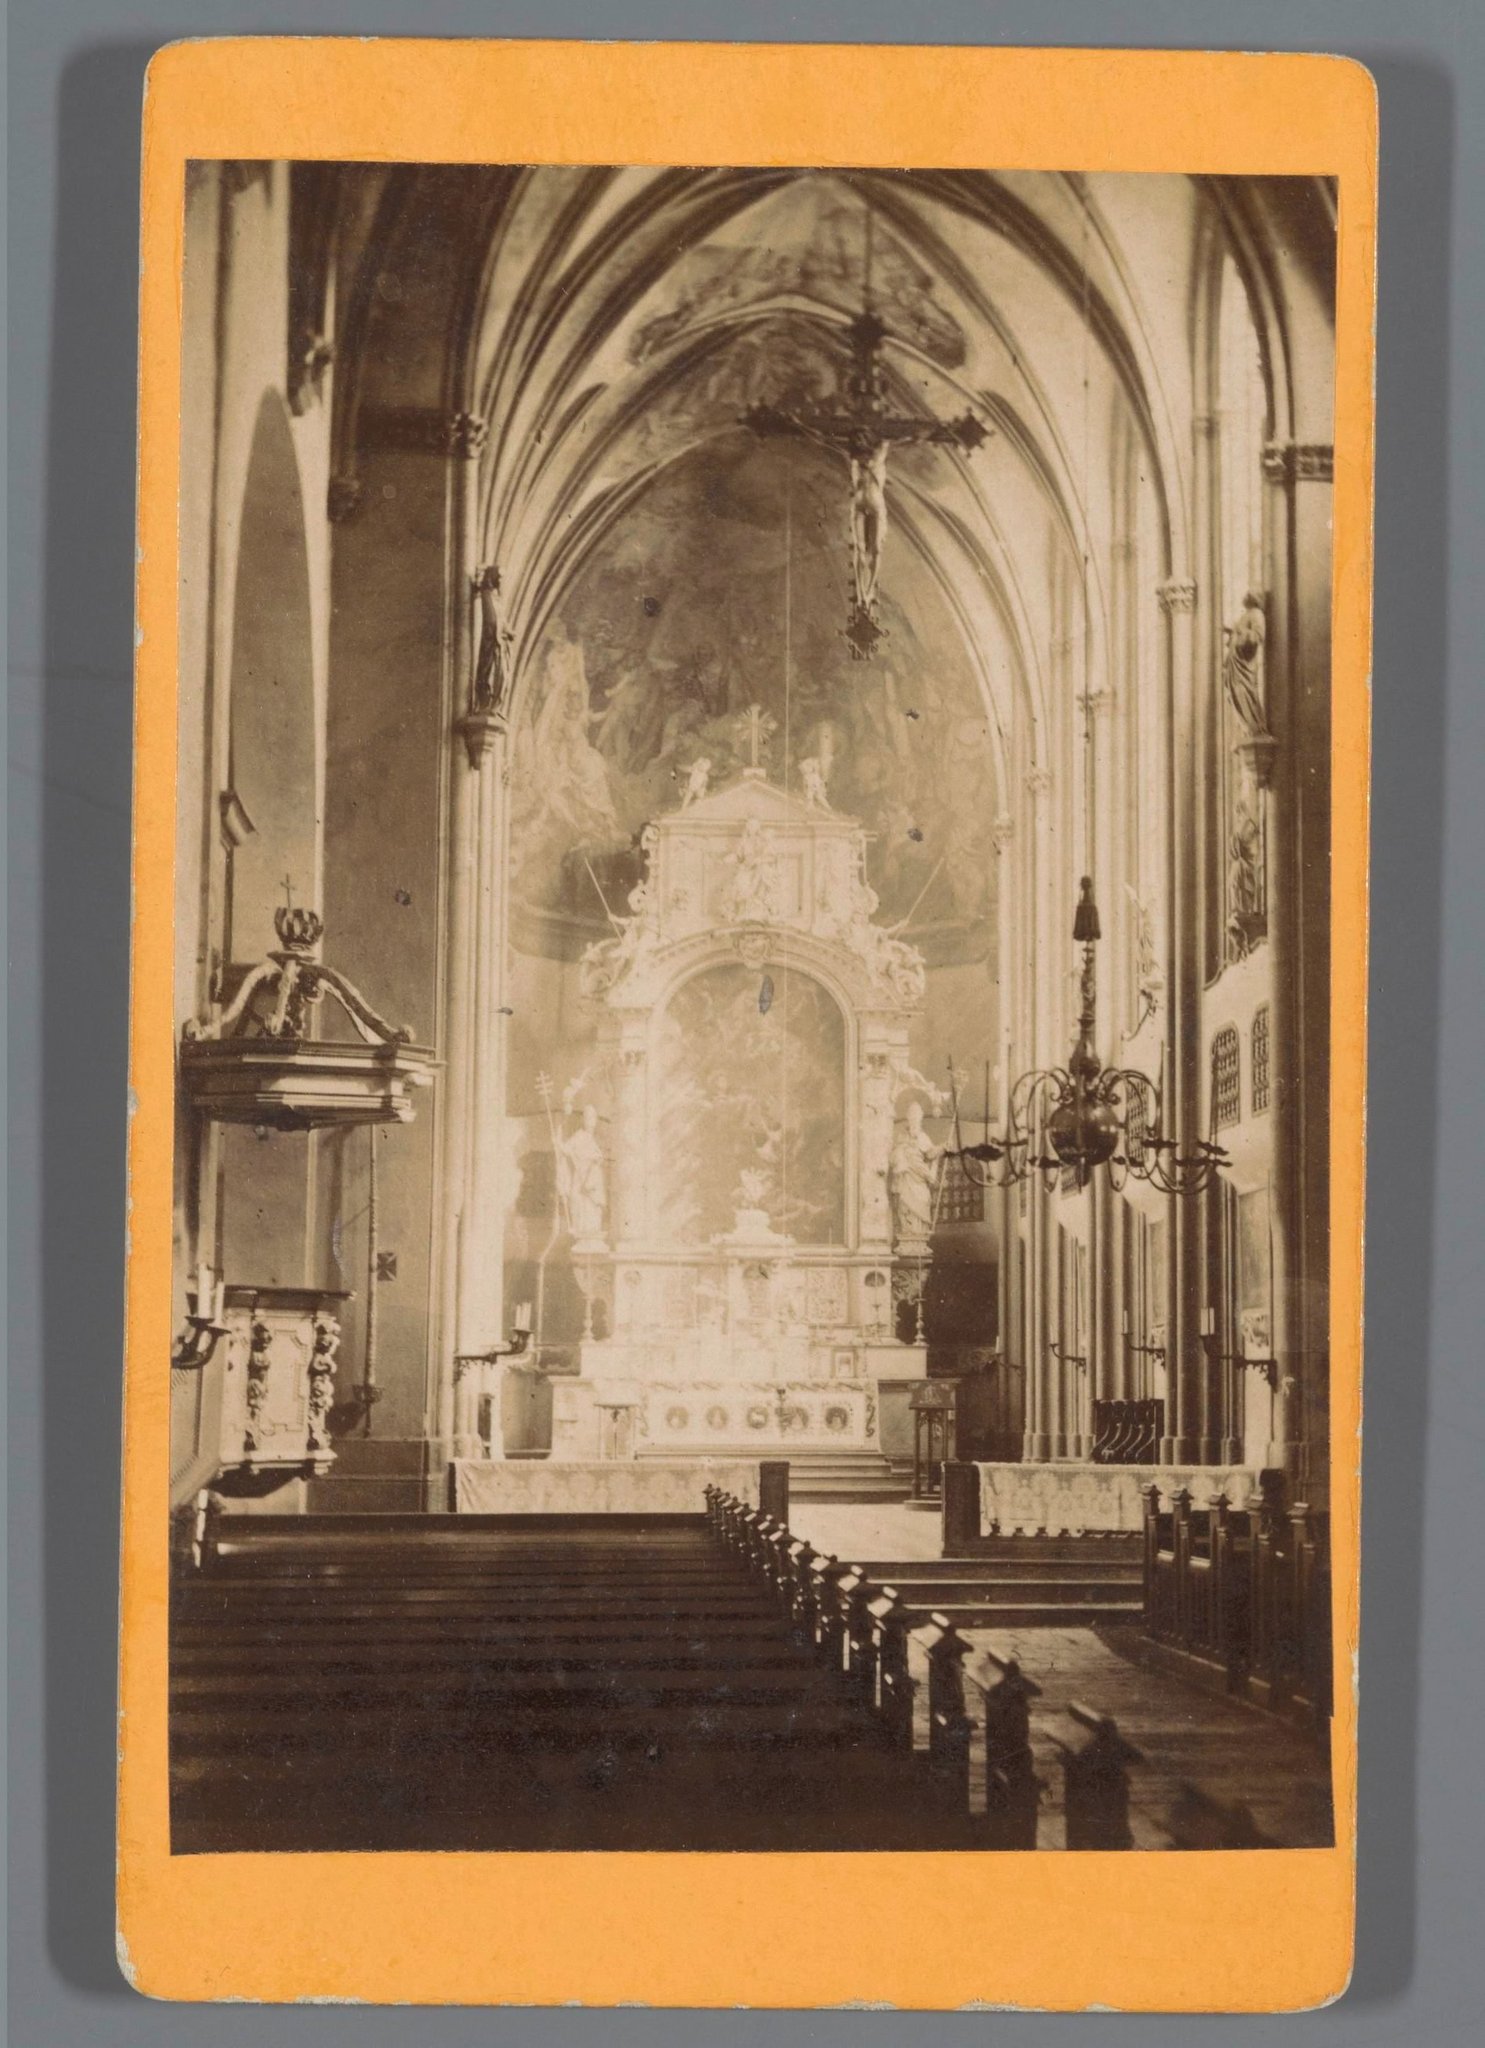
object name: carte de visite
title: St. Ursula, innere Ansicht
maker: theodor creifelds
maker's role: publisher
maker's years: 1815-1875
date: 1855-1875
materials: cardboard, paper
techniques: albumen print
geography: cologne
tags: parts of church interior: choir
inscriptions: number: ‘Nro. 38.’, inscription: ‘Photographische Anstalt/ von/ Th: Creifelds/ in/ CÖLN./ Domkloster.’